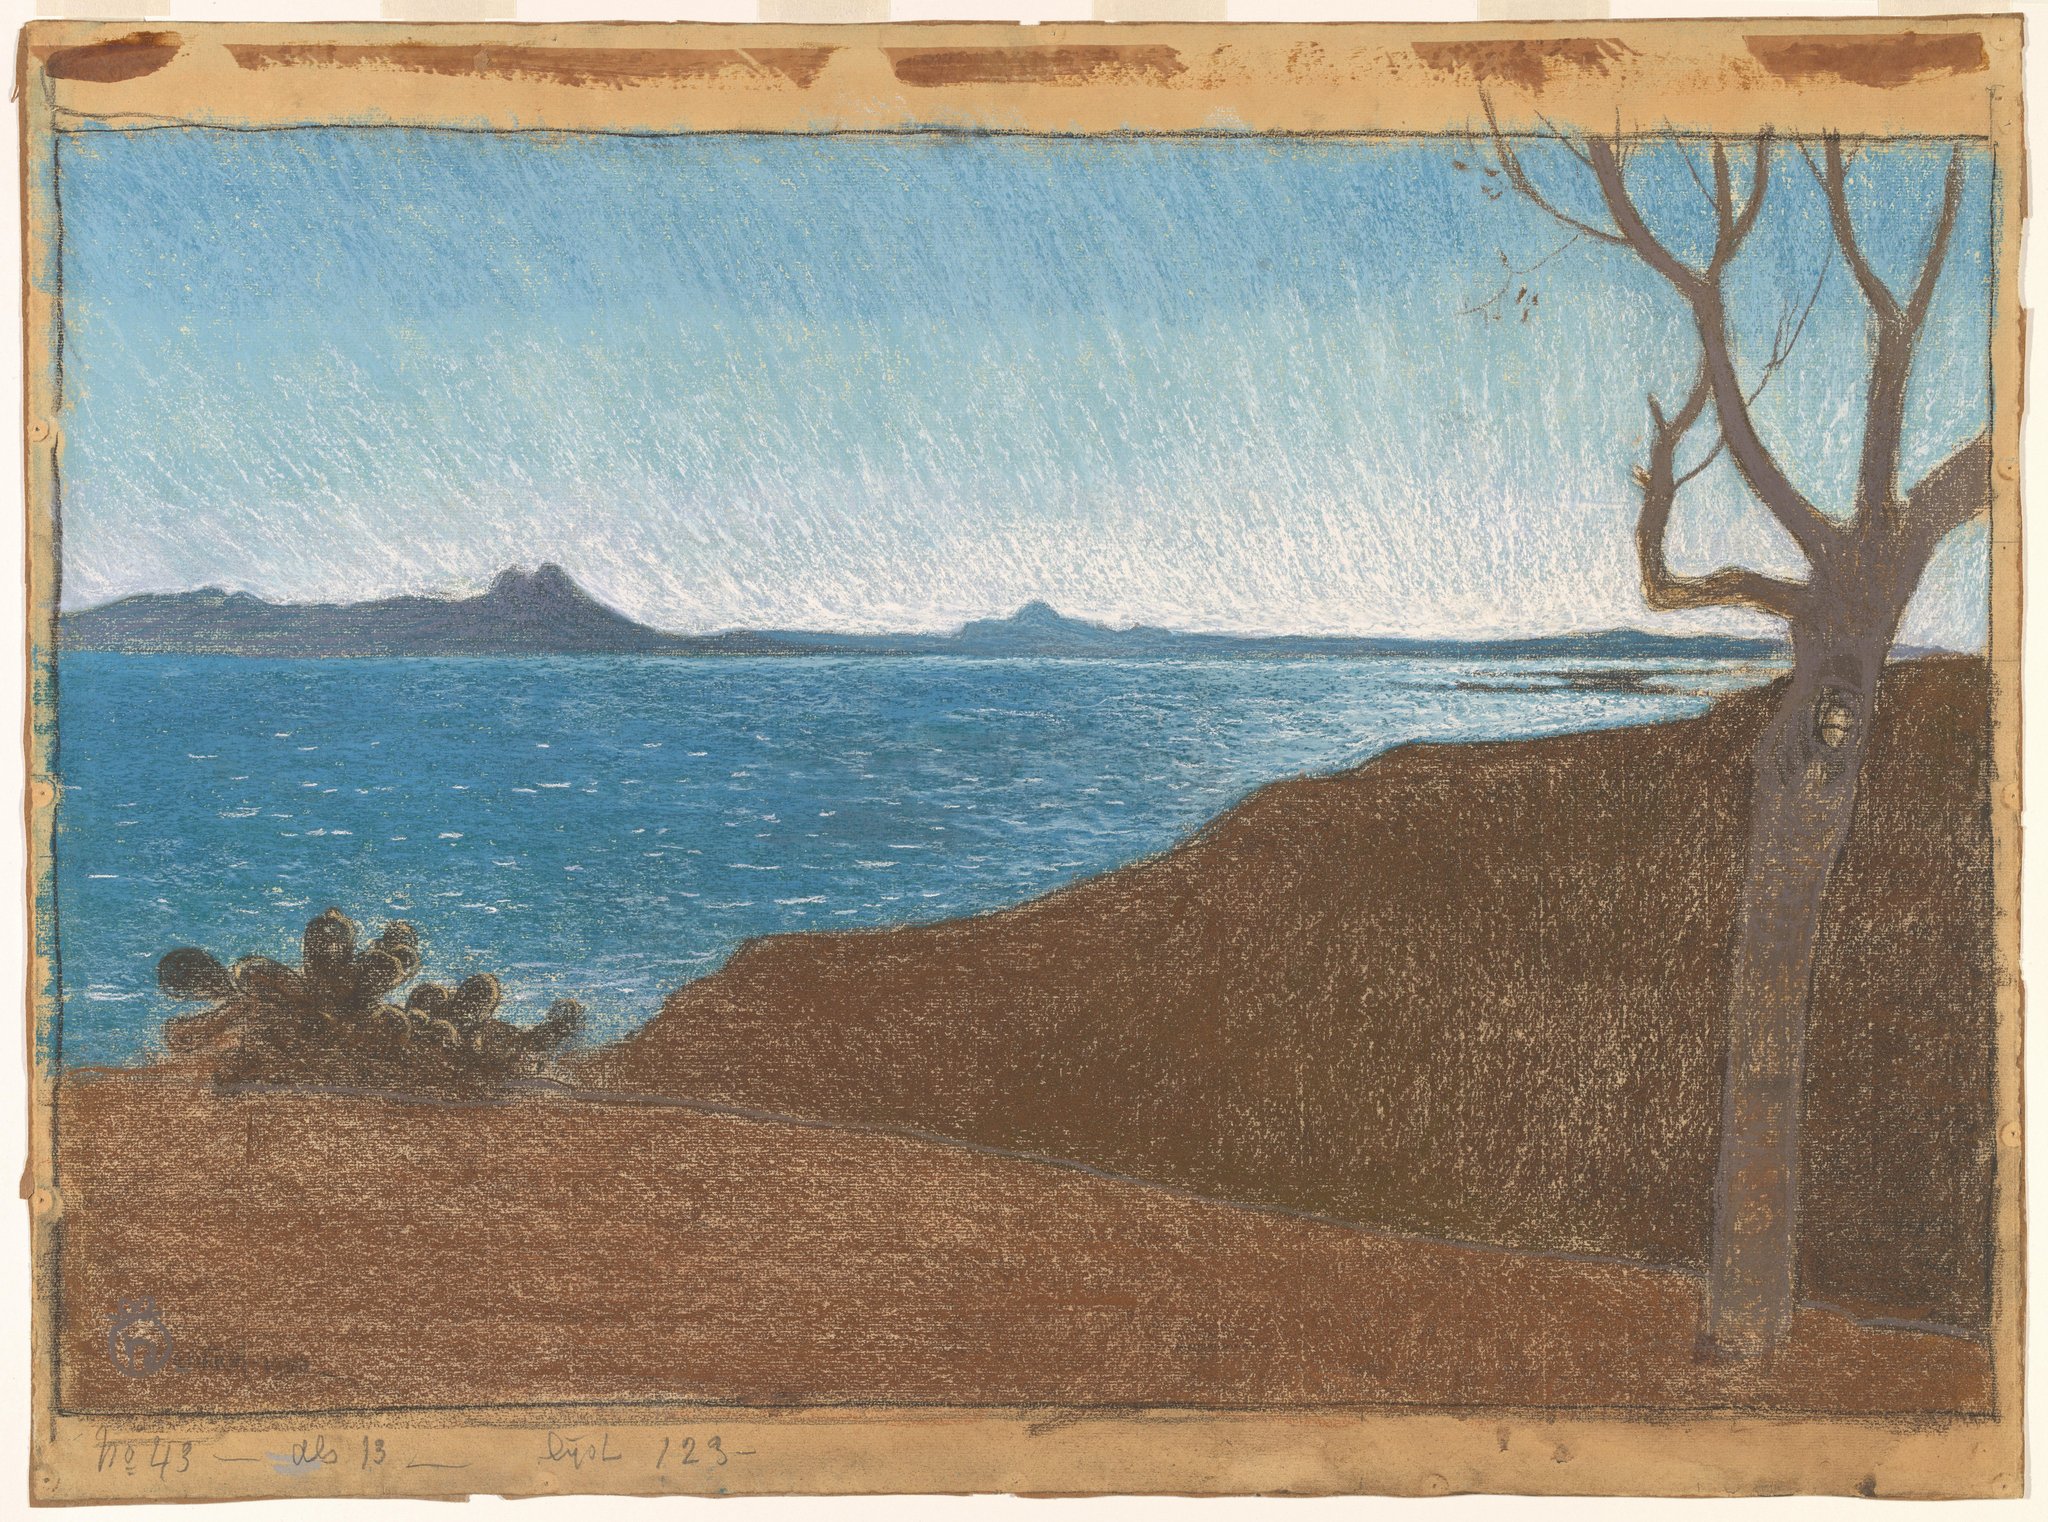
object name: drawing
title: Langs de kust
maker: henricus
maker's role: draughtsman, print maker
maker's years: 1867-1921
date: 1900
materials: paper, pastel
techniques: drawing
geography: netherlands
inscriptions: signature and date: ‘Henricus ... 1900’, inscription: ‘no. 43 - als 13 - lijst 123 -’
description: Tentoongesteld in het Singer Museum Laren van 2014-05-29 t/m 2014-08-31: Droomkunst 1900 & 2000. En ook: Den Haag, Haagsche Kunstkring, Tentoonstelling van Pastels en Teekeningen uit Saïd-bou-Saïd door Henricus, 1901-1902, no. 39 (fl. 175). Leiden, Vereeniging De Laecken-Halle, Tentoonstelling van Pastels uit Saïd-bou-Saïd door Henricus, s.a., no. 9 (als eigendom van P.F. Mess; fl. 175).